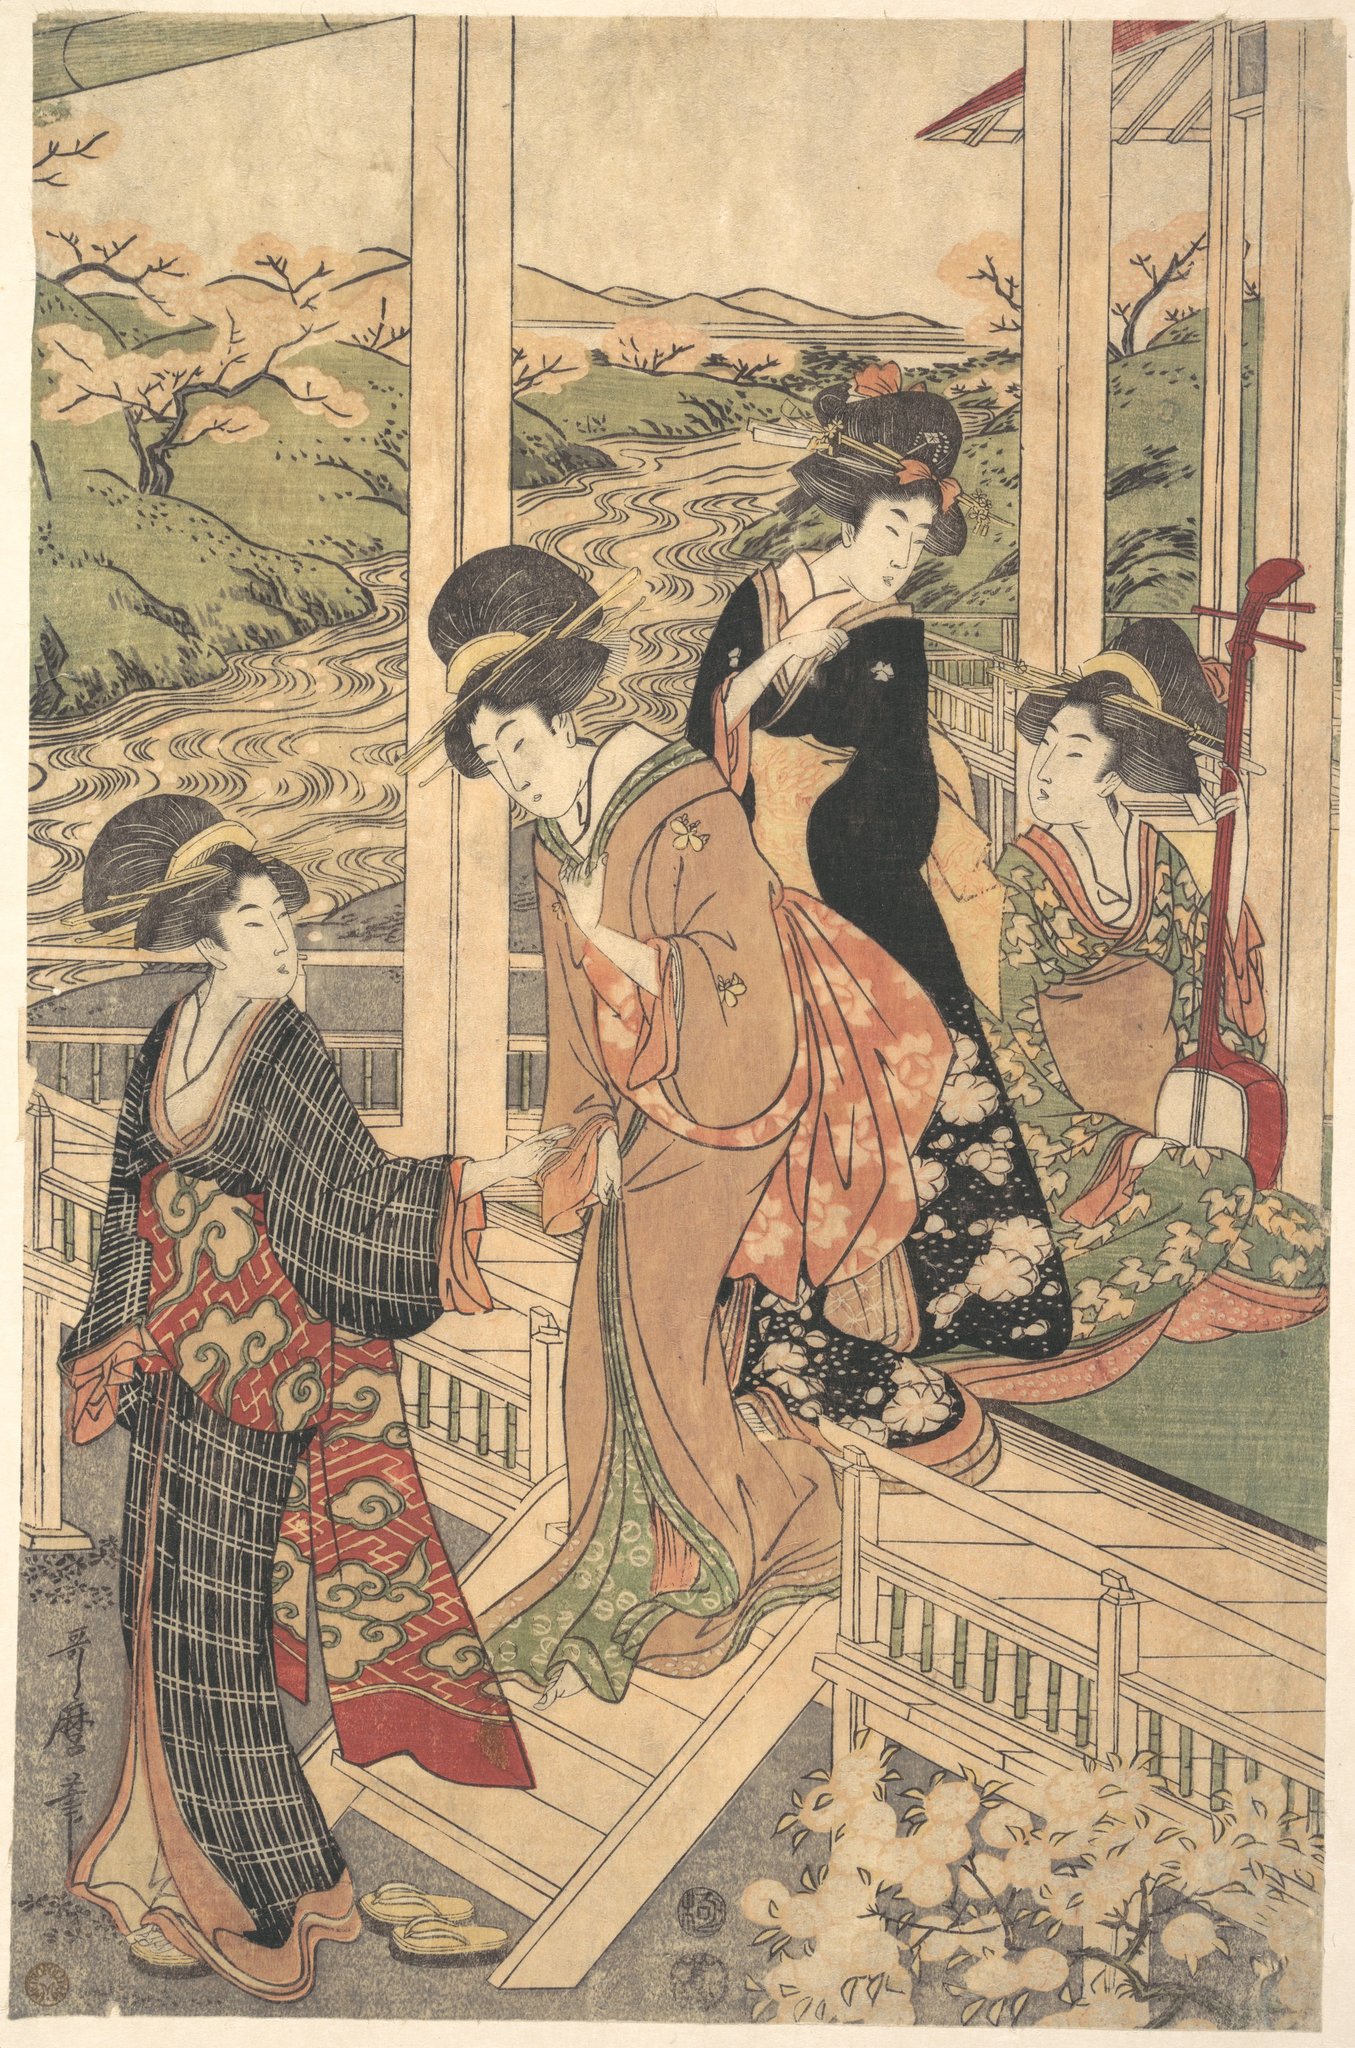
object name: woodblock print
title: Group of Women on the Engawa of a Country House, in the time of the Cherry Blossoming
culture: japanese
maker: utamaro ii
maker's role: artist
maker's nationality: japanese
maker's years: 1750-1850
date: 1806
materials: ink, paper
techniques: woodblock print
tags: musical instruments,women,rivers,hills,trees